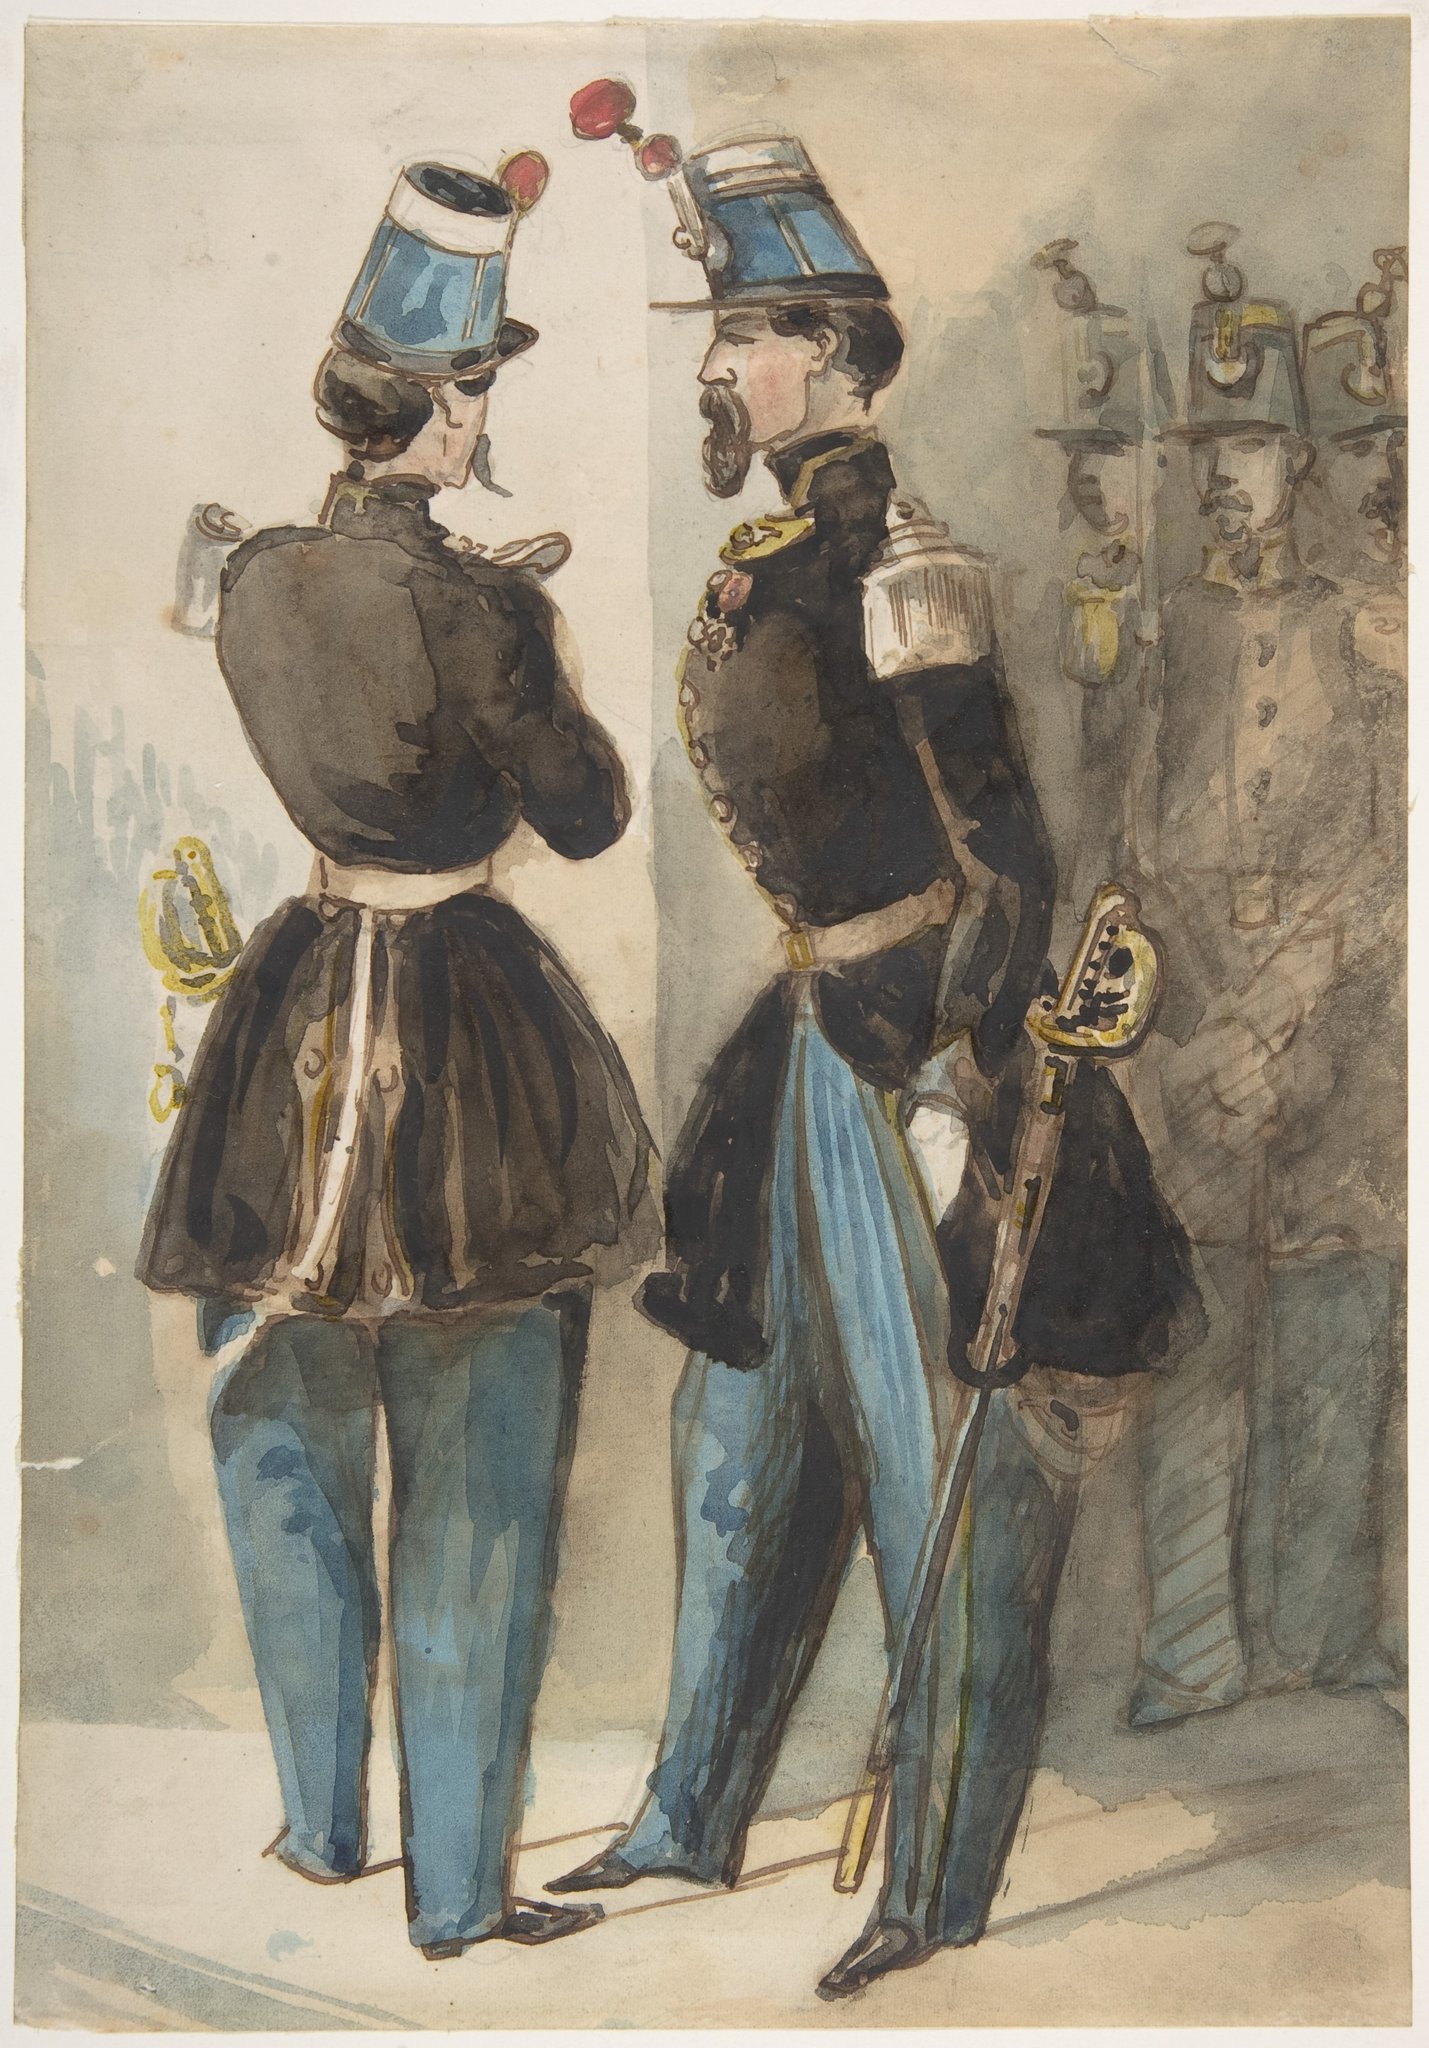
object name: drawing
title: Officers of the Guard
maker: constantin guys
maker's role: artist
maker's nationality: french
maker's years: 1802-1892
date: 1801-1900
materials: graphite, ink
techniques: pen, wash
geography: france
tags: men